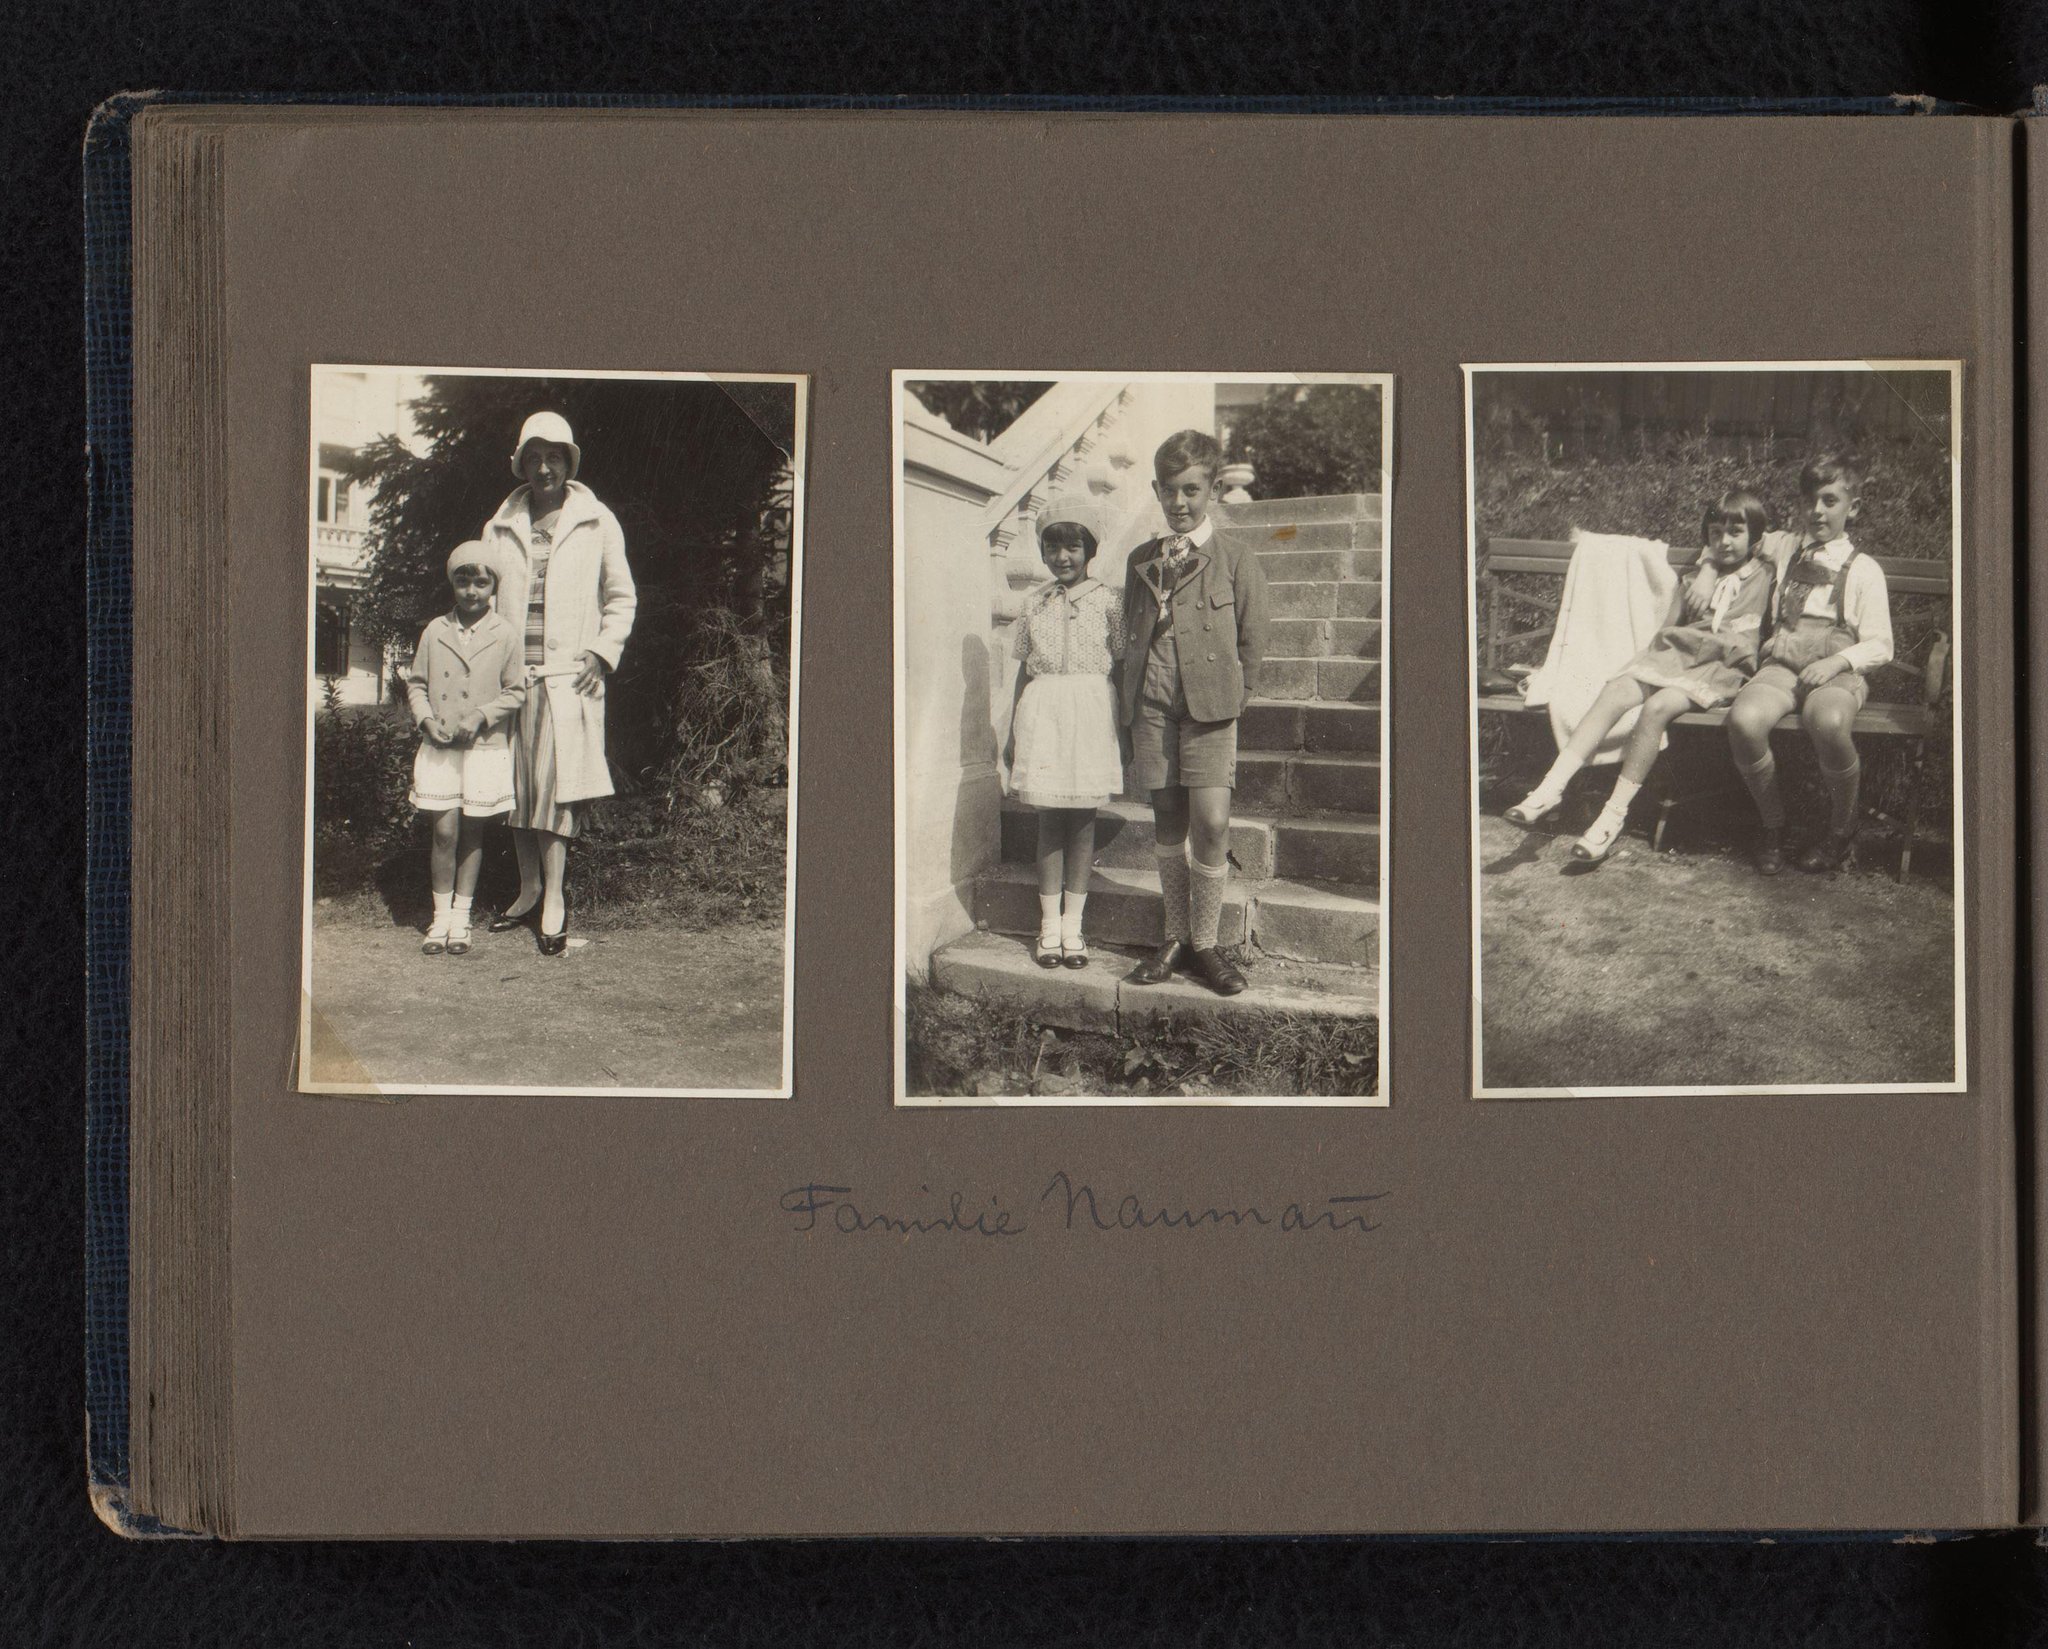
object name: photograph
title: Kinderen van de familie Naumann, vermoedelijk na juli 1932, vermoedelijk in Albeck (Oostenrijk)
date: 1907-1932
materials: paper, photographic support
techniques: gelatin silver print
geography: austria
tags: austria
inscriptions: inscription: ‘Familie Naumann’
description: Albumblad bevat drie foto's van kinderen van de familie Naumann. Uit album half formaat, blauw kunstlederen omslag met koordbinding.